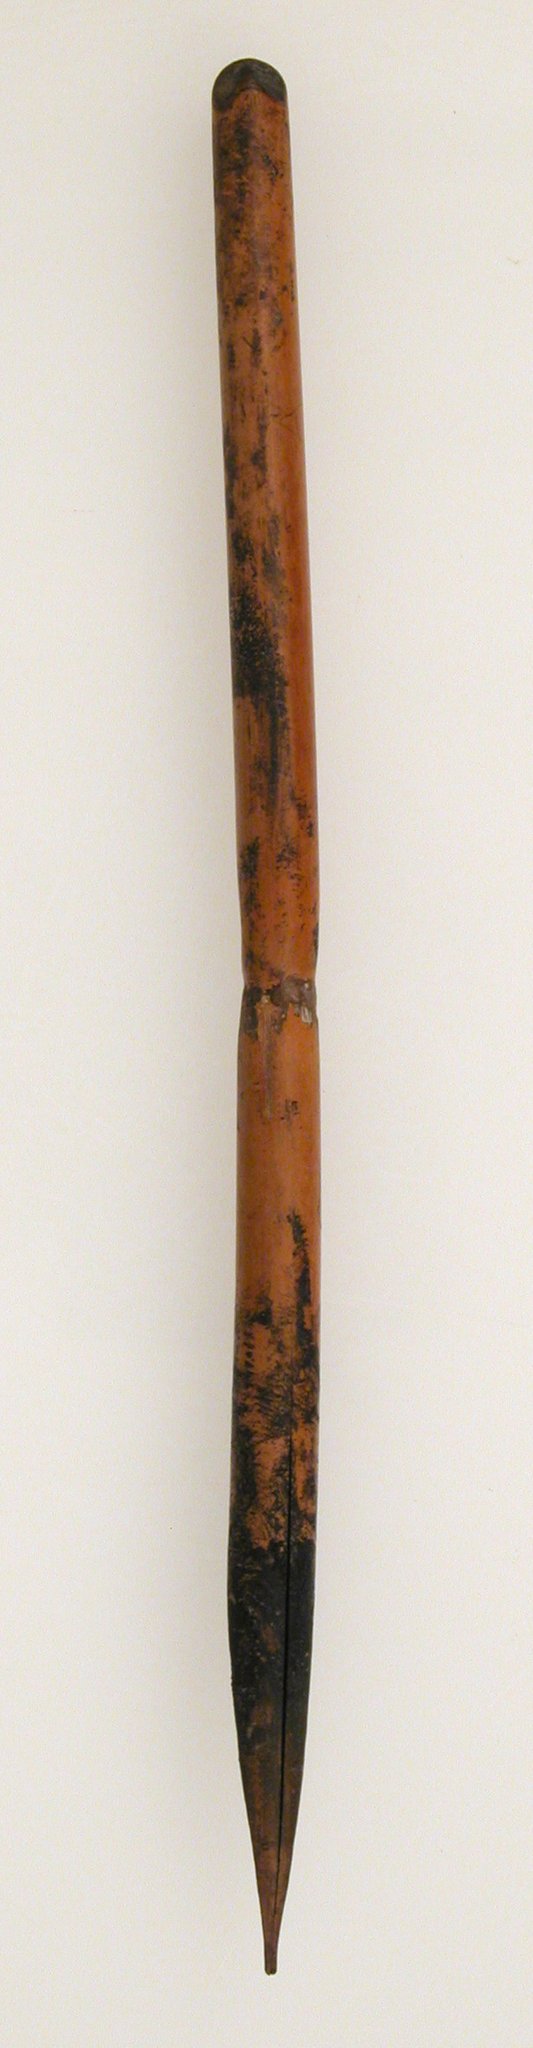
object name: pen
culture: coptic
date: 580-640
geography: egypt